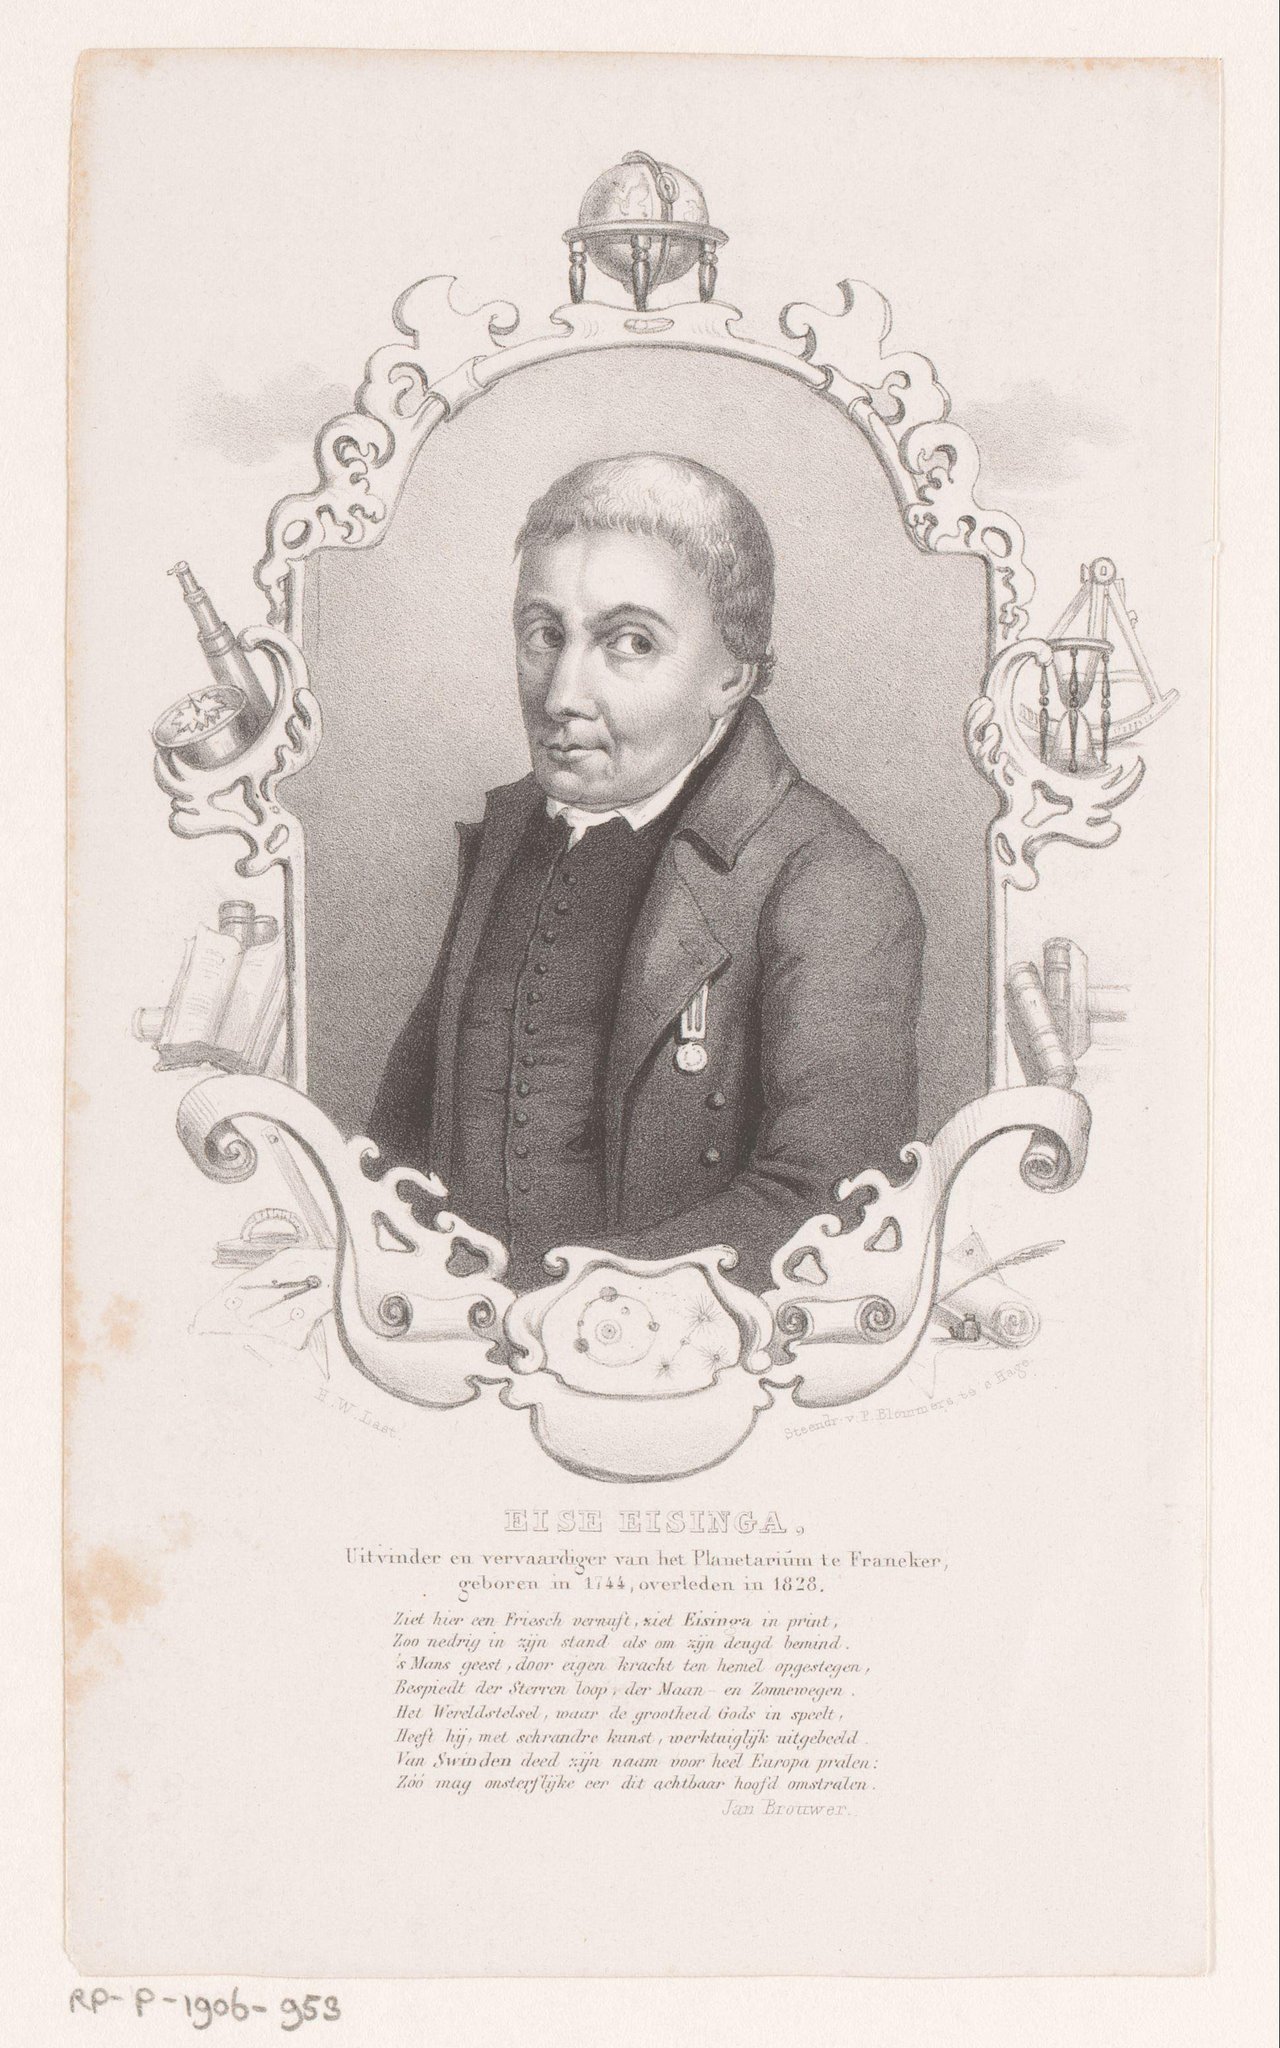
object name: print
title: Portret van Eise Eisinga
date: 1842-1887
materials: paper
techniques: lithograph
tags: knighthood order, telescope, globe, historical persons (+ (full) bust portrait)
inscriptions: collector's mark: Lugt 2228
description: De geportretteerde draagt een ridderorde en is weergegeven in een ornamentrand met objecten die verwijzen naar zijn beroep, zoals een globe en sterrenkijker. Eisinga was astronoom en bouwde een planetarium. Onder het portret een gedicht door Jan Brouwer.